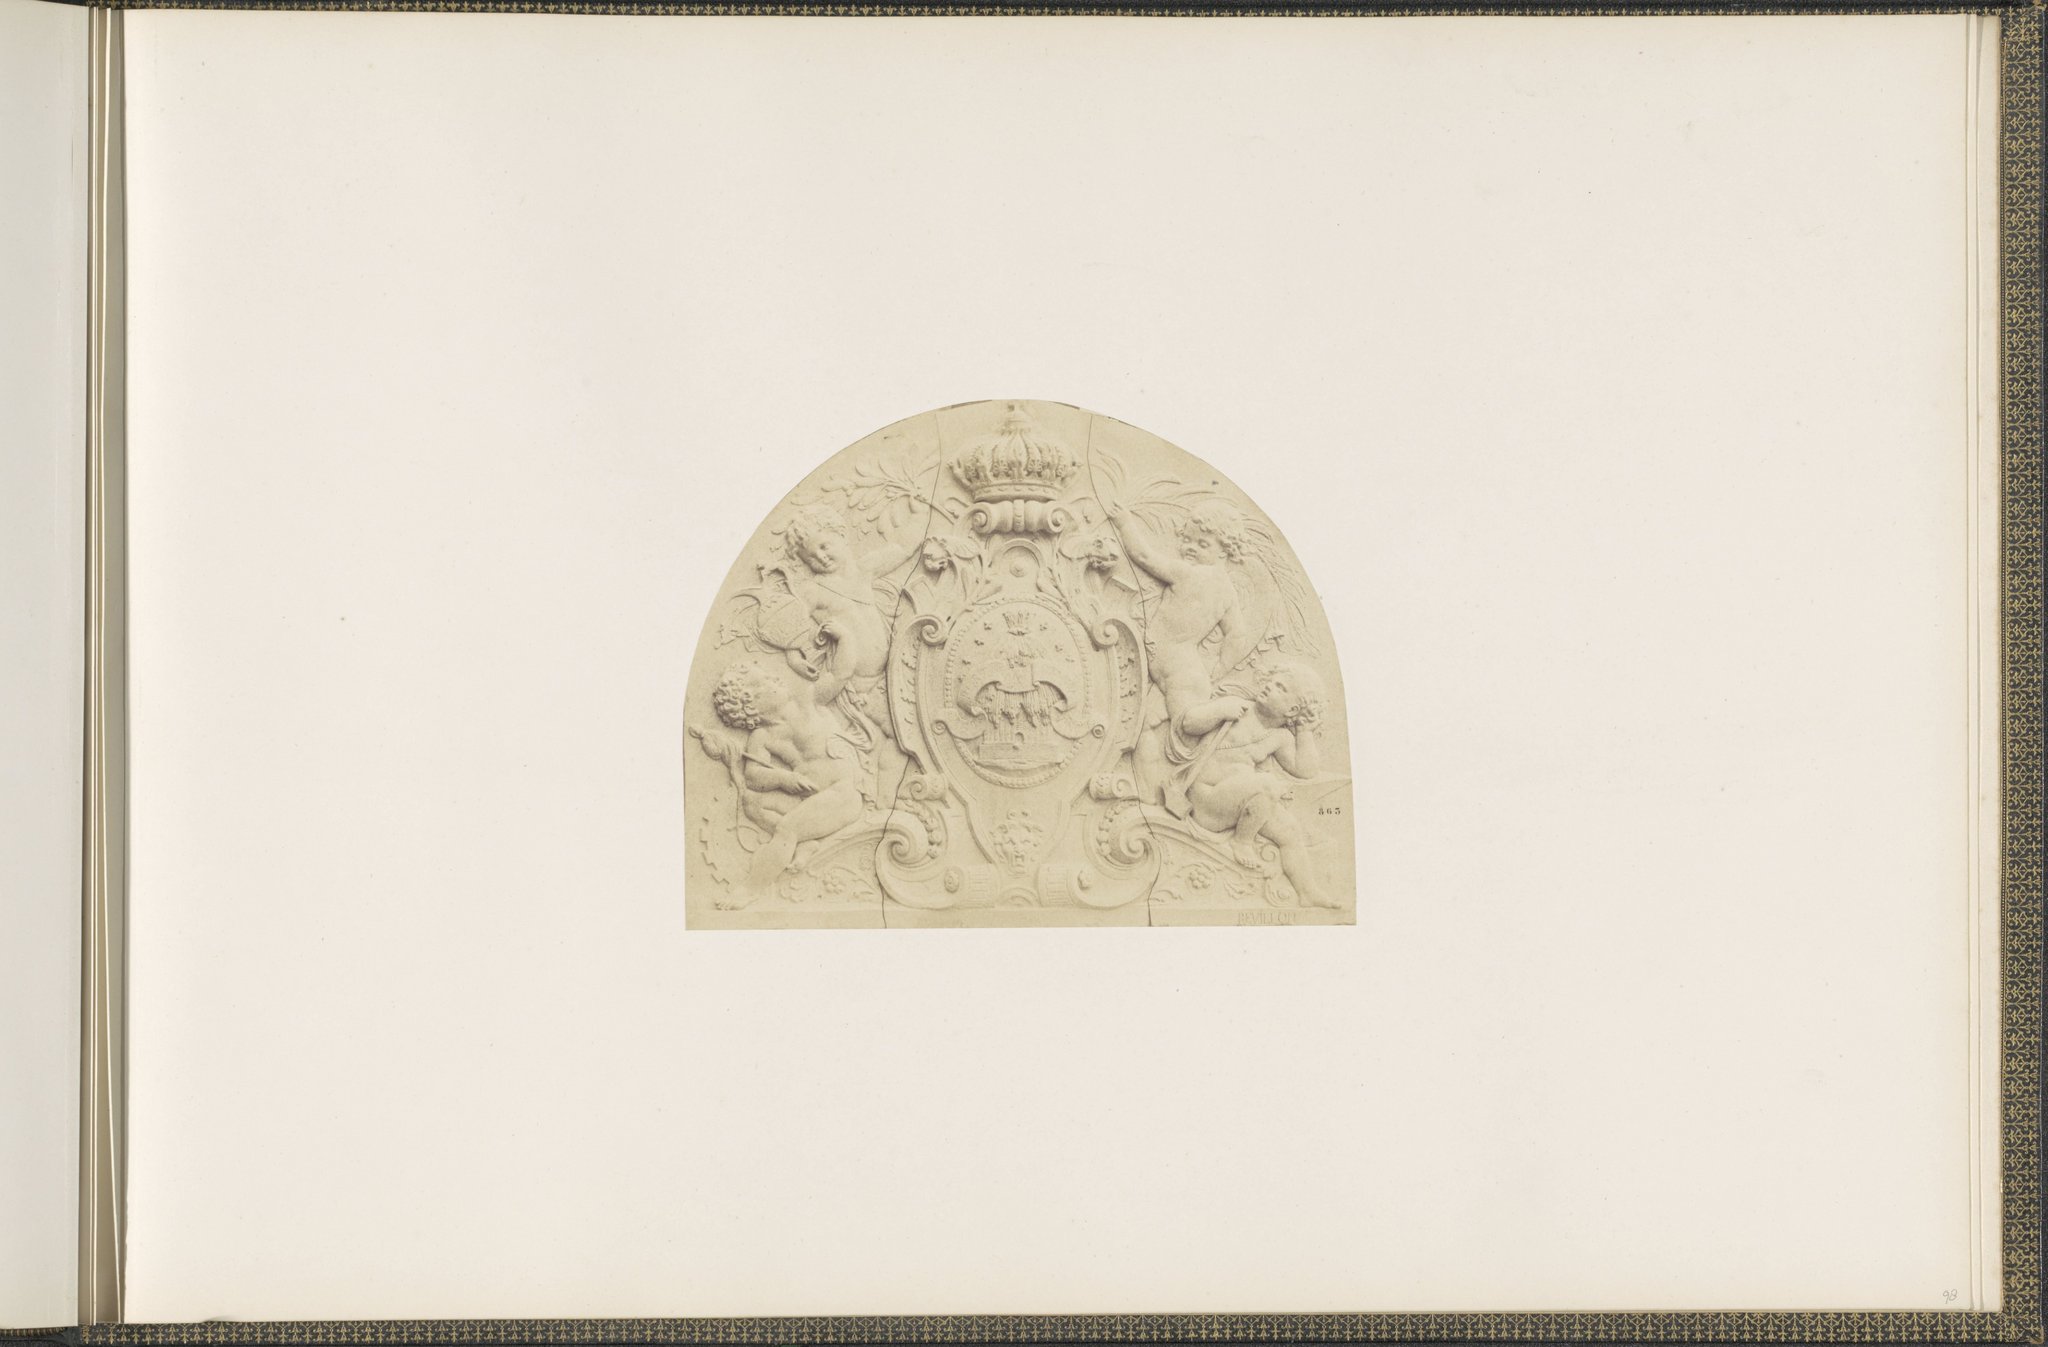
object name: photograph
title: Gipsmodel voor beeldhouwwerk op het Palais du Louvre: "L'Industrie" door Jean-Baptiste Revillon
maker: édouard denis baldus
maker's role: fotograaf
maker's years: 1813-1889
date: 1855-1857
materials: paper, photographic support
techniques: salted paper print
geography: paris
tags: piece of sculpture, reproduction of a piece of sculpture, permanent exhibition, museum, paris, tuileries palace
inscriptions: number: ‘863’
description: Onderdeel van Réunion des Tuileries au Louvre 1852-1857, album 4.